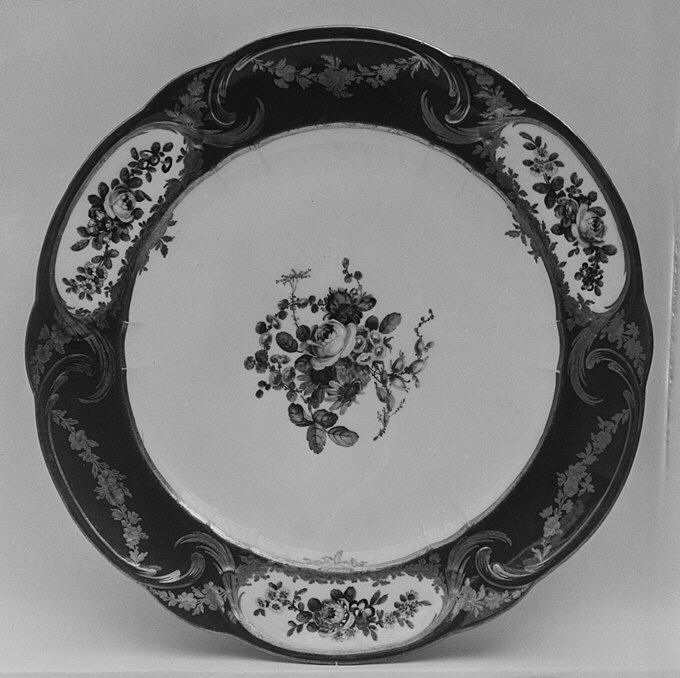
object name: plate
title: Plate (assiette à palmes) (1 of 102) (part of a service)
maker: sèvres manufactory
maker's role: manufactory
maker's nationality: french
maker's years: 1740-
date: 1767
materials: soft paste porcelain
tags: roses